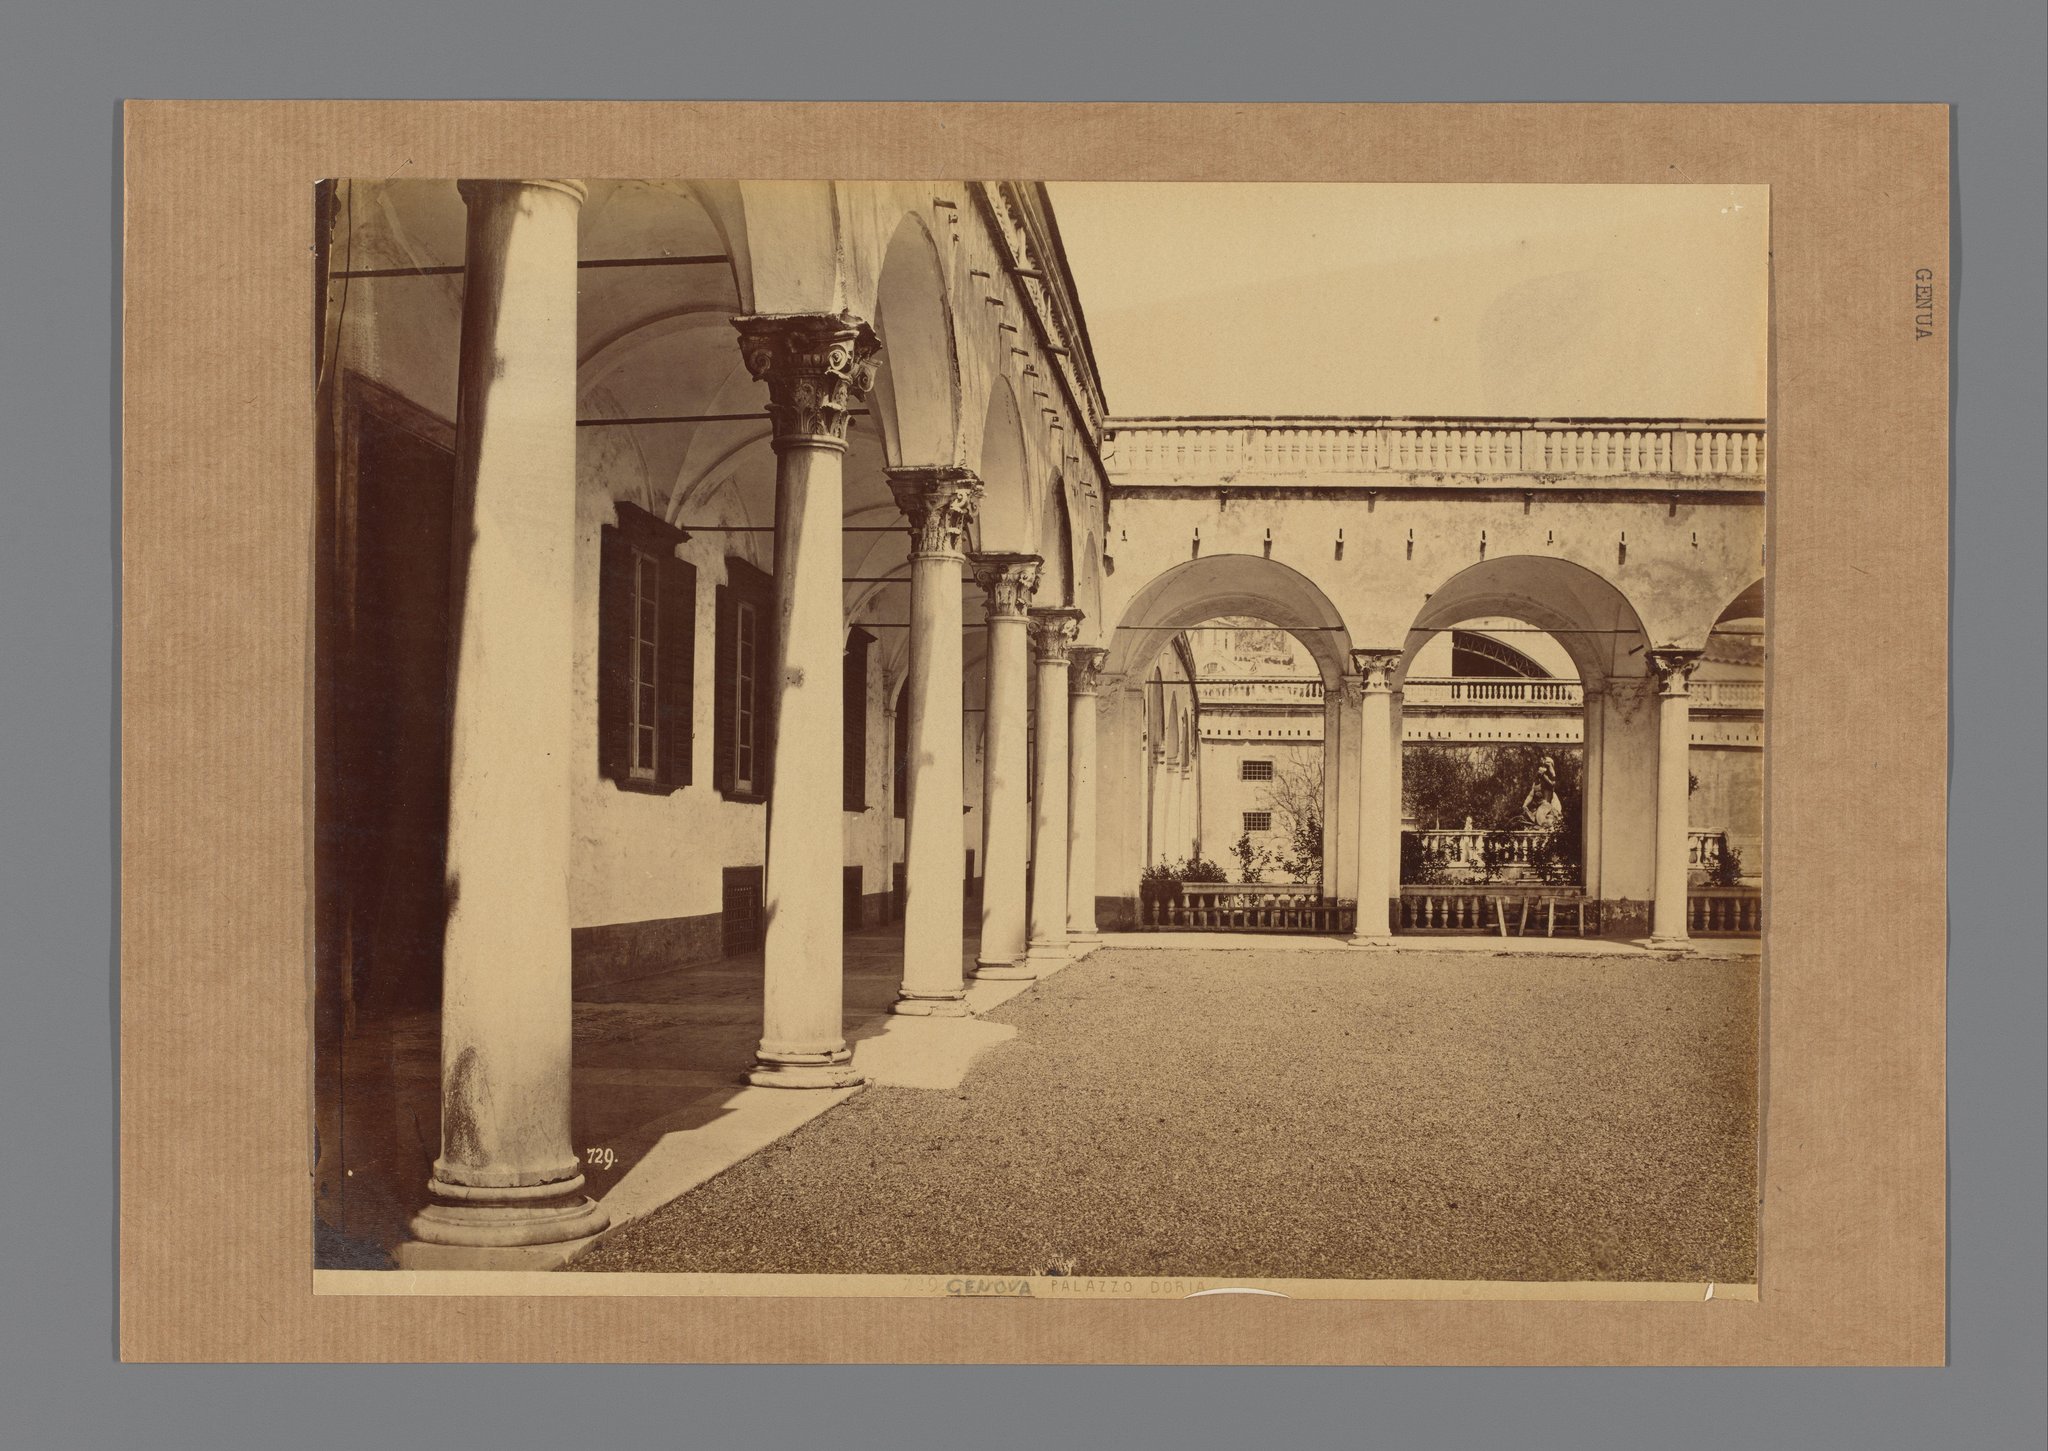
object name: photograph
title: Italië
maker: Anonymous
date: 1880-1910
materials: photographic support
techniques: albumen print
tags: italy